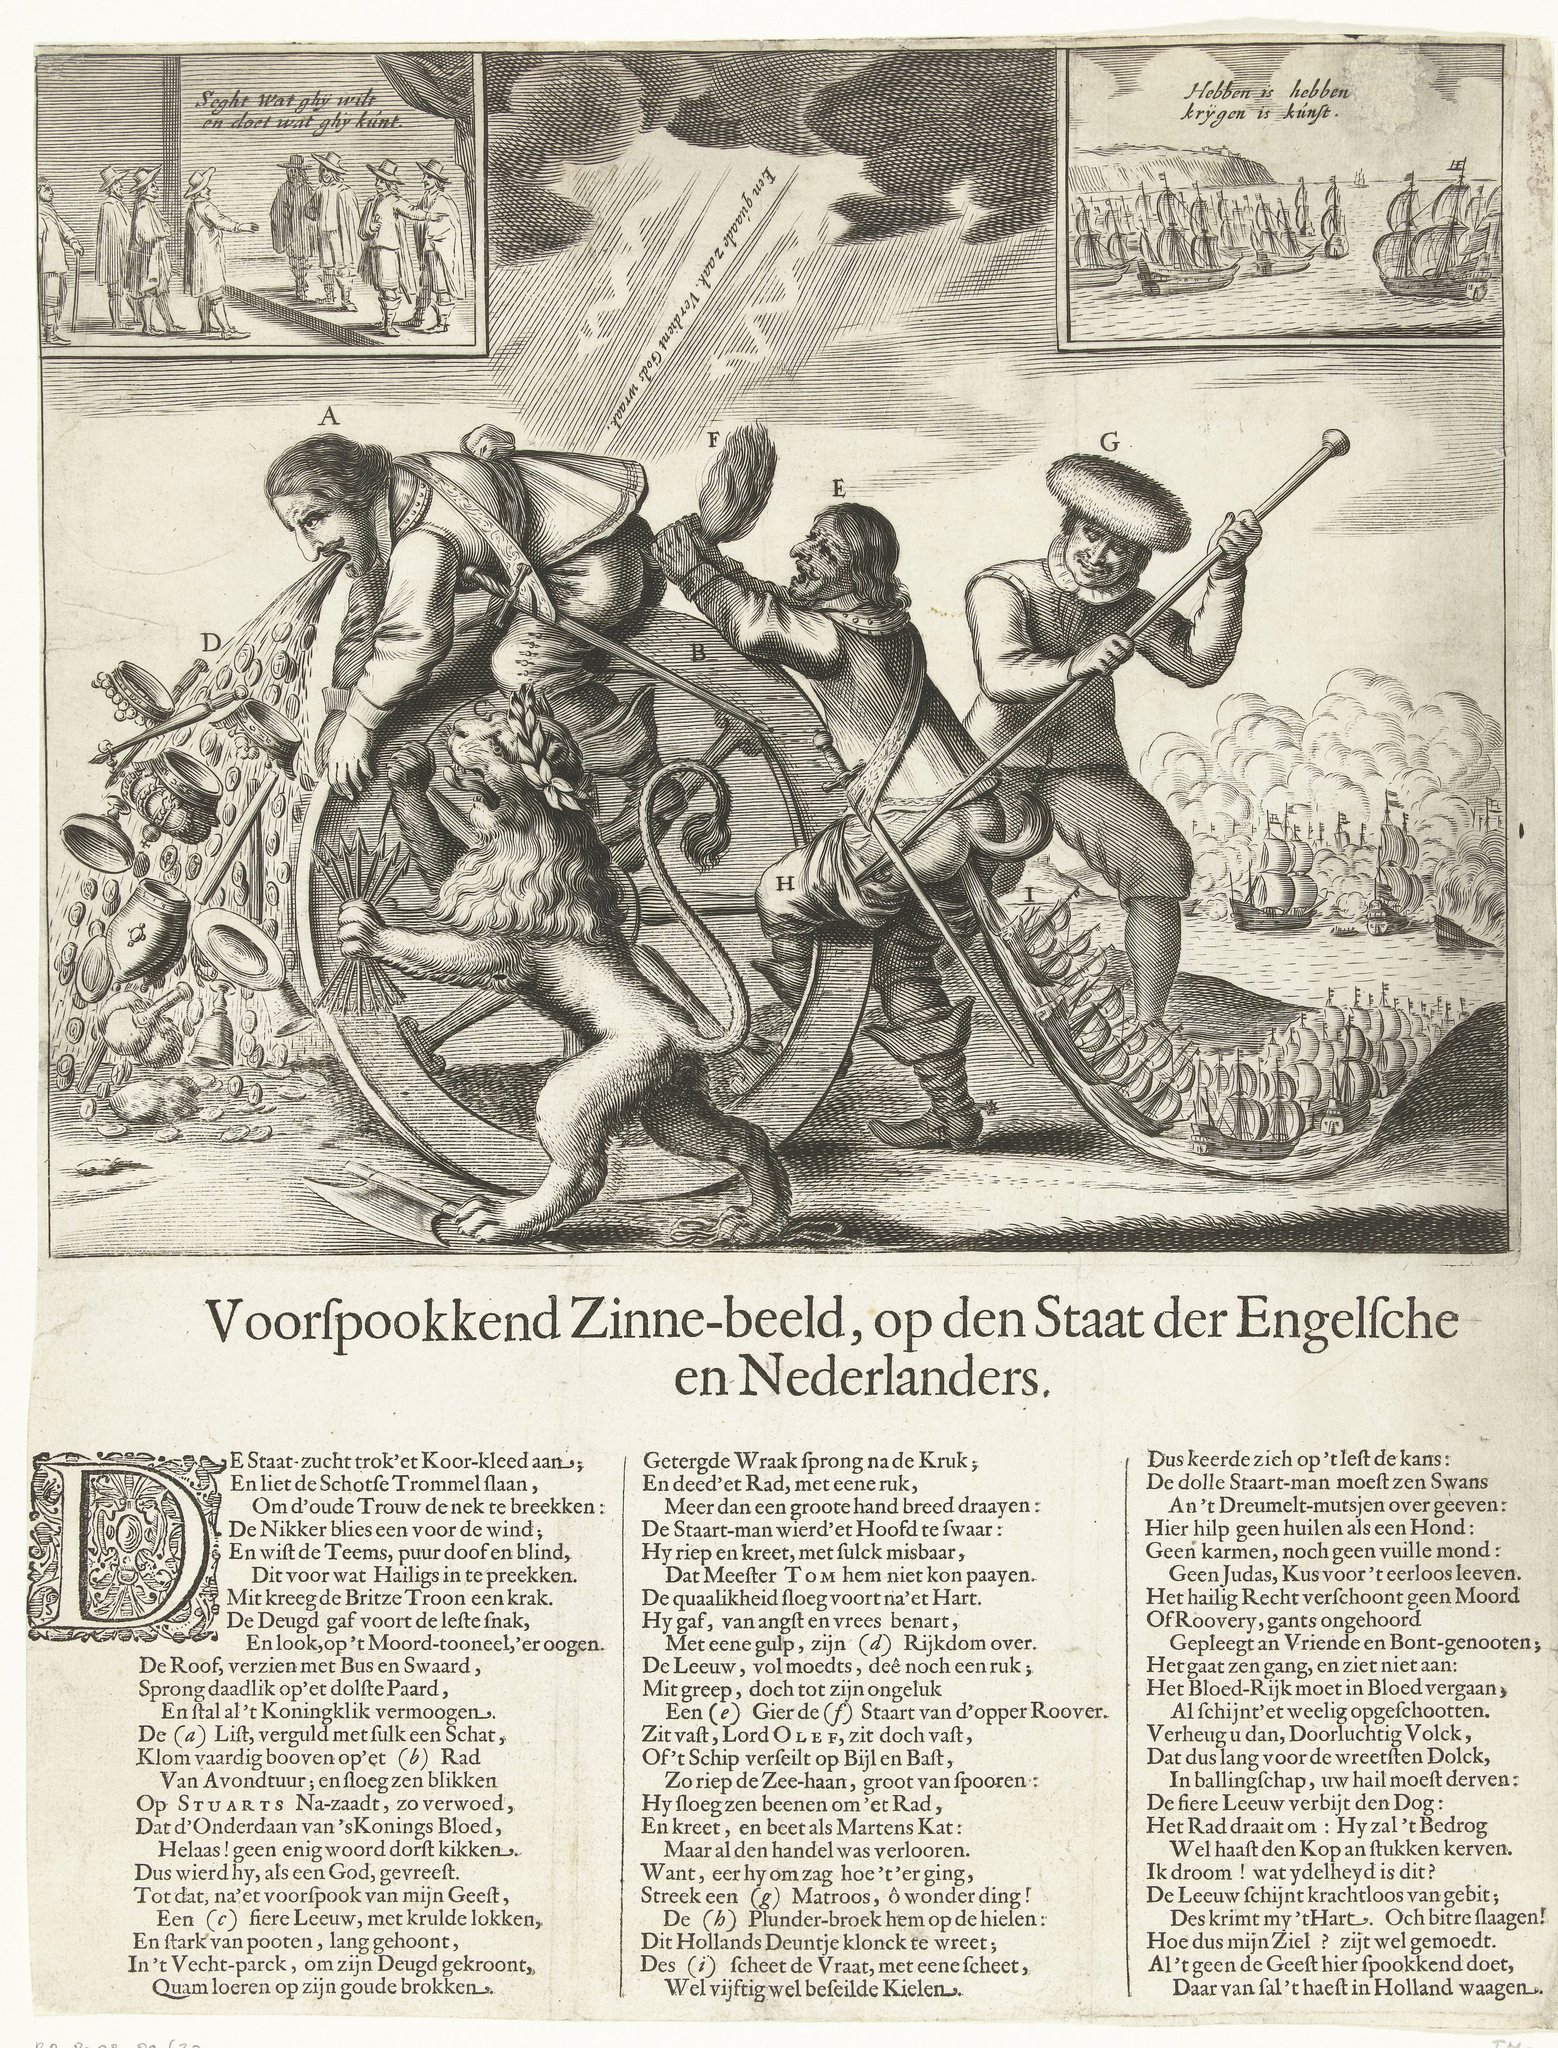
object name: cartoon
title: Spotprent op de Engelsen, 1652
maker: Anonymous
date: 1652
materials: paper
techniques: engraving, letterpress printing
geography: northern netherlands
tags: london, oliver cromwell, battle (+ naval force), turn of fate, wheel of fortune, political caricatures and satires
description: Spotprent op de Engelsen, 1652. Oliver Cromwell en een andere Engelsman (admiraal Blake?) liggend op het rad van Fortuin gedraaid door de Hollandse Matroos en de Nederlandse Leeuw. Uit de mond van Cromwell worden de geroofde rijkdommen gespuugd, bij de ander wordt een vloot van oorlogsschepen uitgescheten. Op de achtergrond een zeeslag. Bovenin twee kleine scènes. Onder de plaat gedrukt een vers van 3 kolommen in het Nederlands.